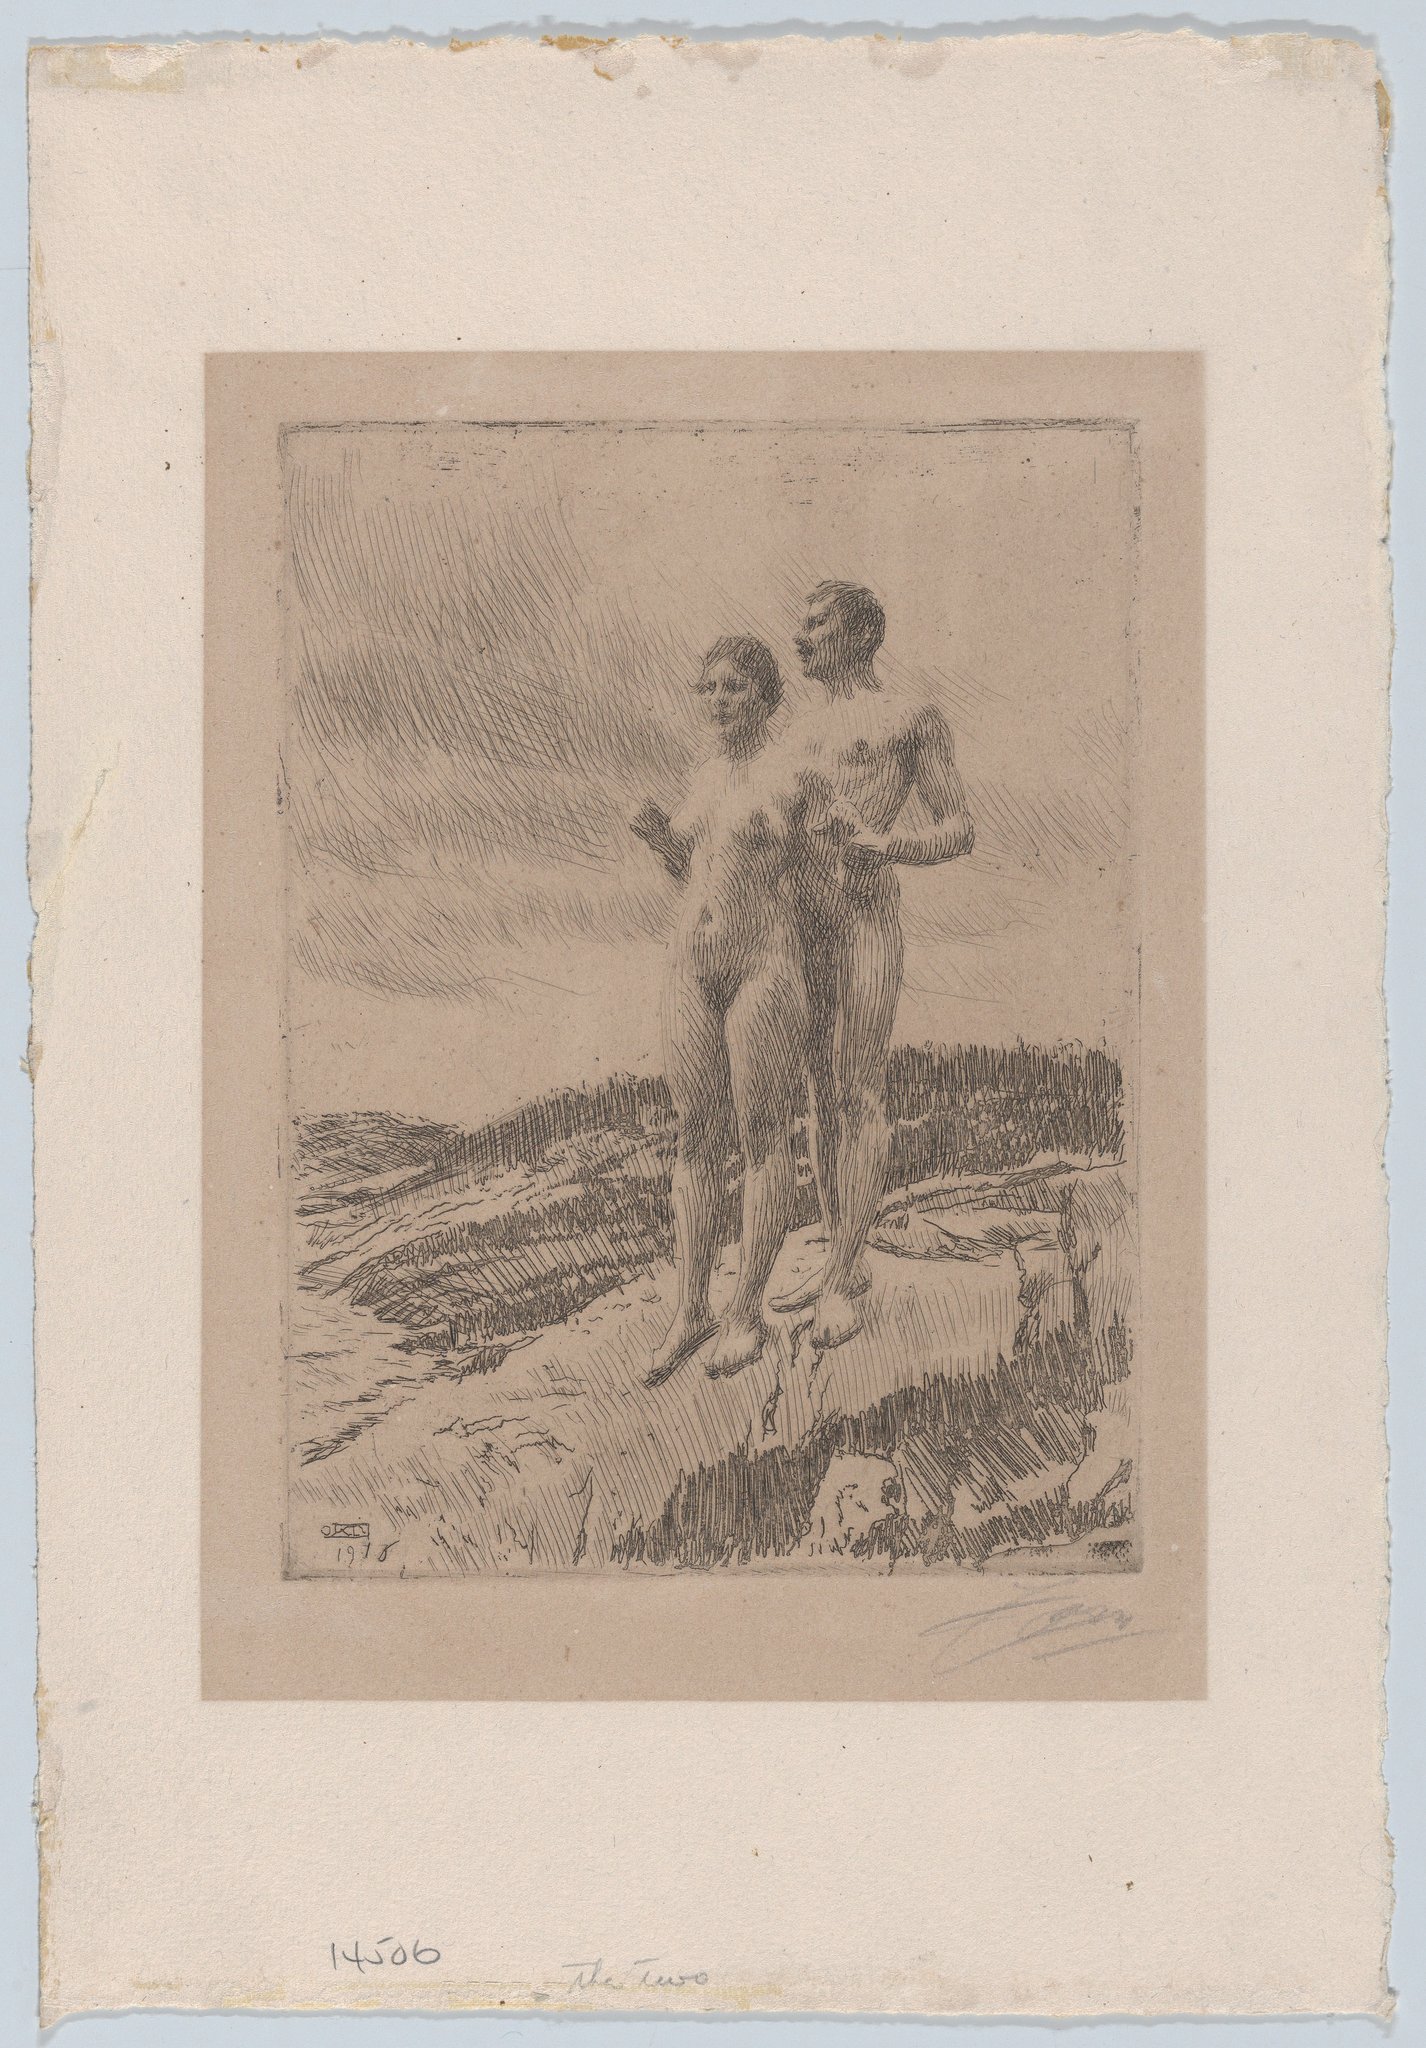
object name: print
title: The Two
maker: anders zorn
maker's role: artist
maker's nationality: swedish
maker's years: 1860-1920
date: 1916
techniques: etching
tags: male nudes,female nudes